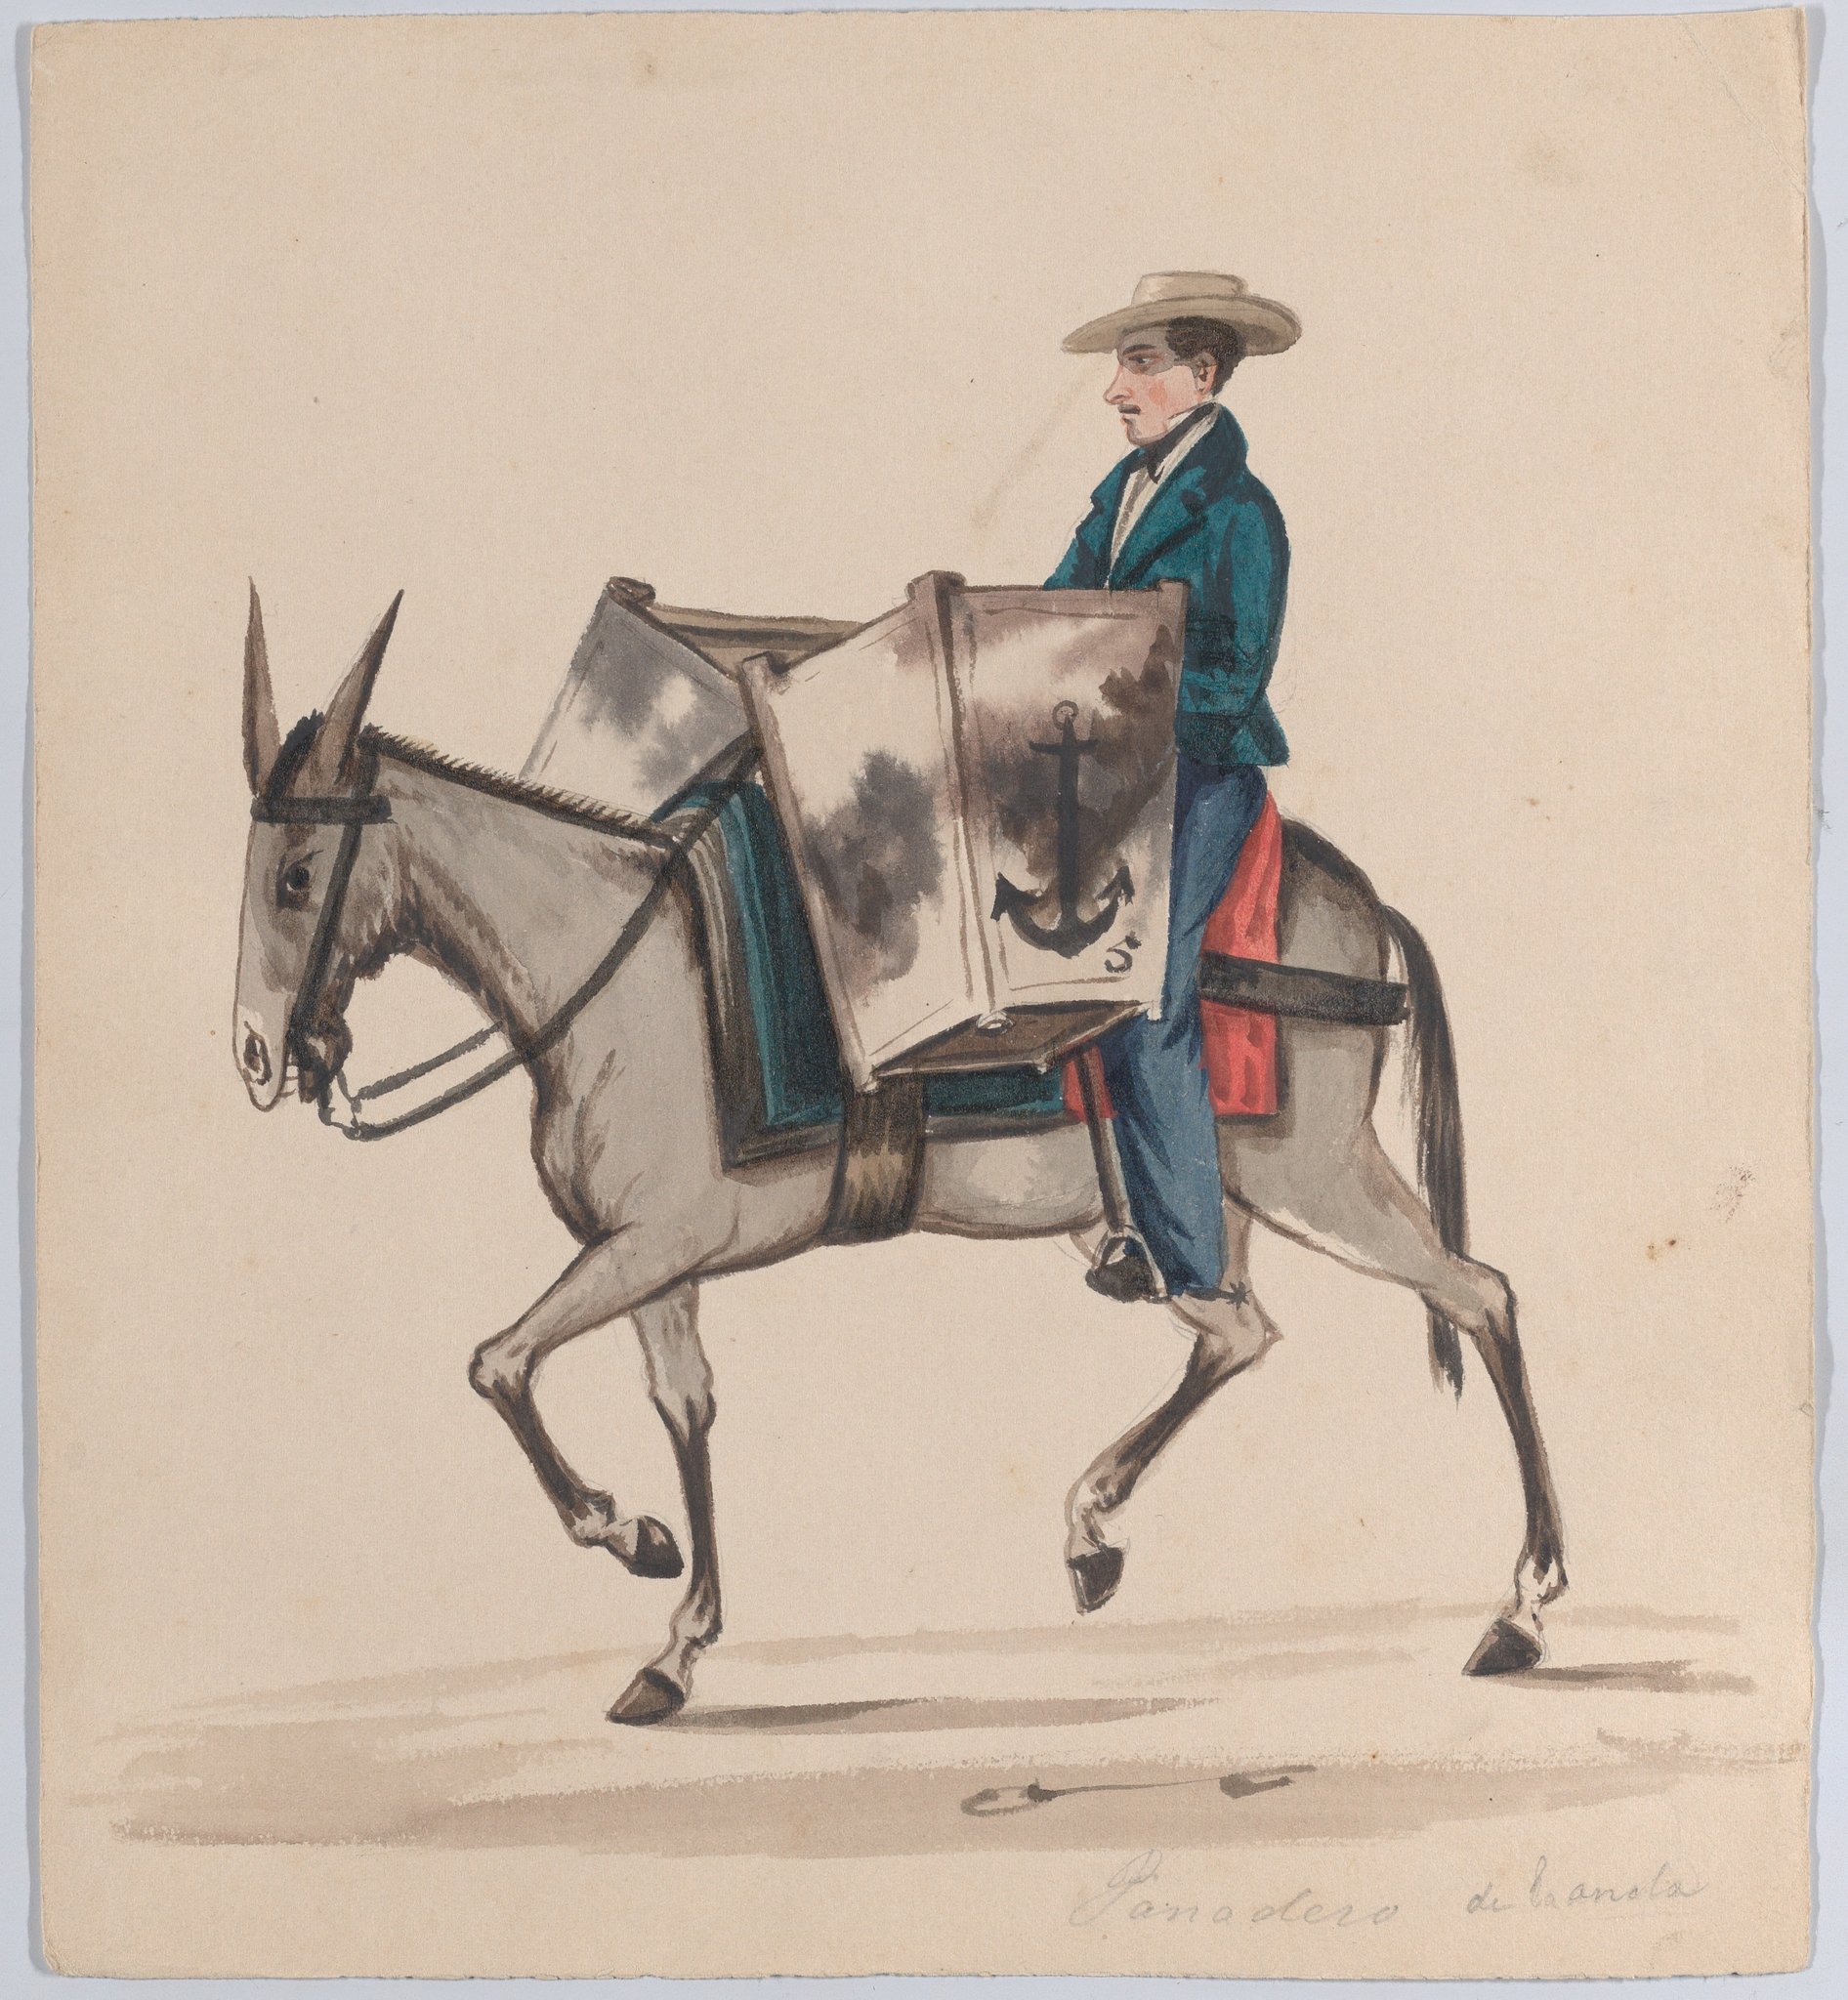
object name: drawing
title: A baker on horseback, from a group of drawings depicting Peruvian dress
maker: francisco (pancho) fierro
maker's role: artist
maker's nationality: african peruvian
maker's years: 1807-1879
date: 1848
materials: watercolor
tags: men,women